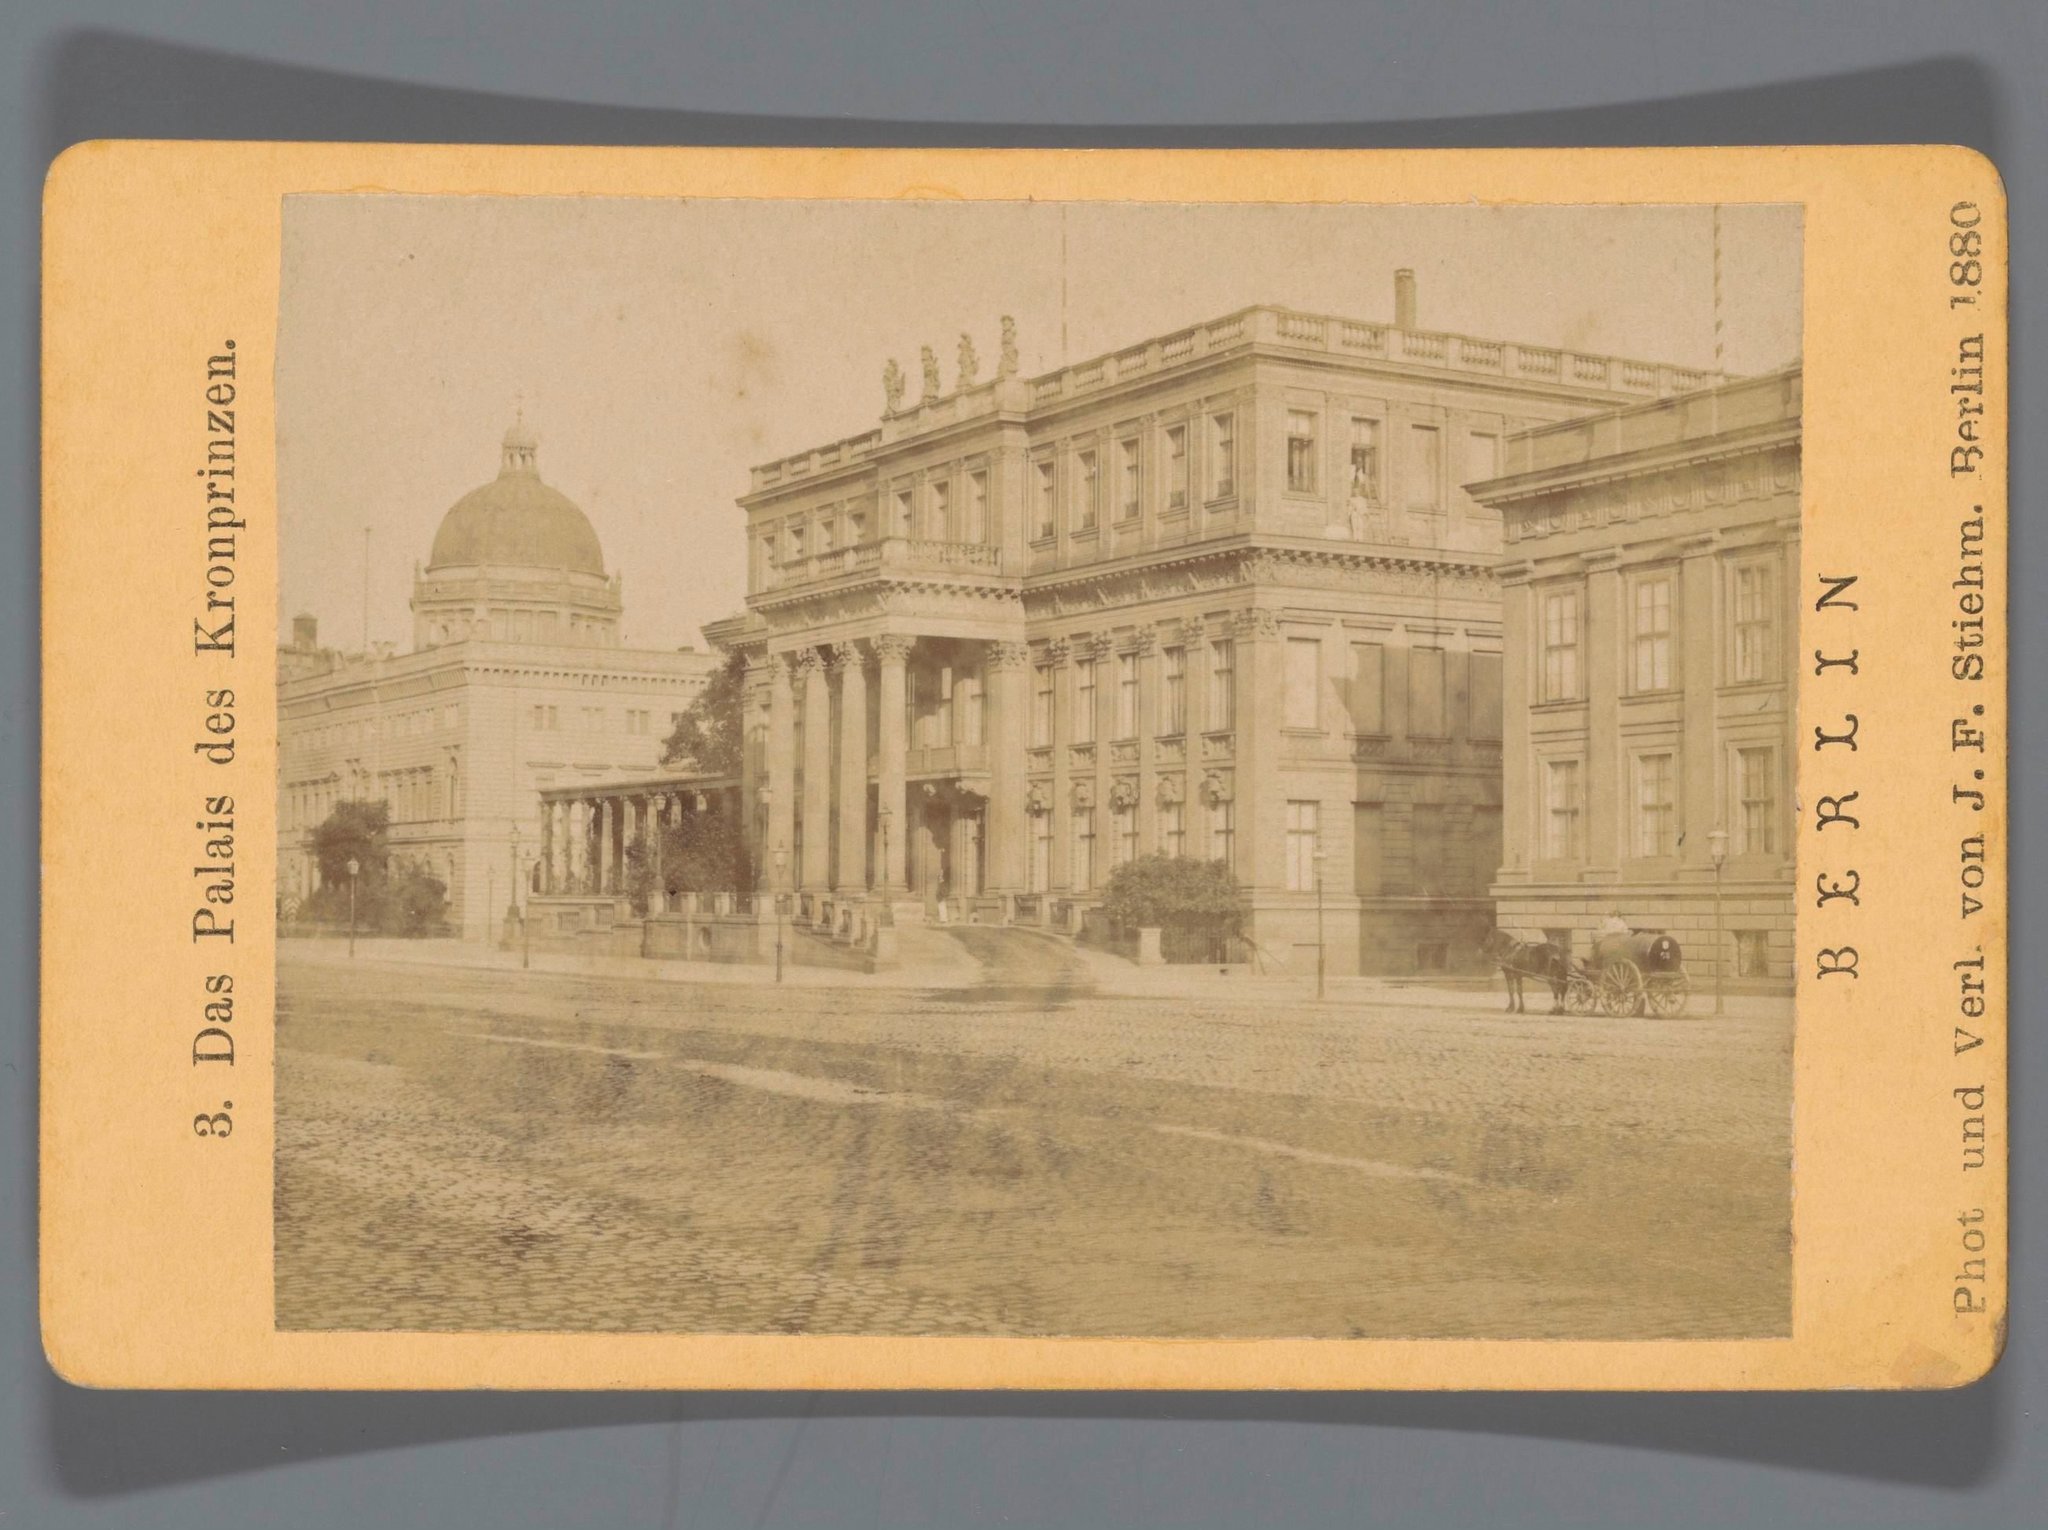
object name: photograph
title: Kronprinzenpalais aan Unter den Linden, Berlijn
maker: johann friedrich stiehm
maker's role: fotograaf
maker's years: 1826-1902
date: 1880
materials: cardboard, paper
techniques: albumen print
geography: berlin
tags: palace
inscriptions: number: ‘3.’